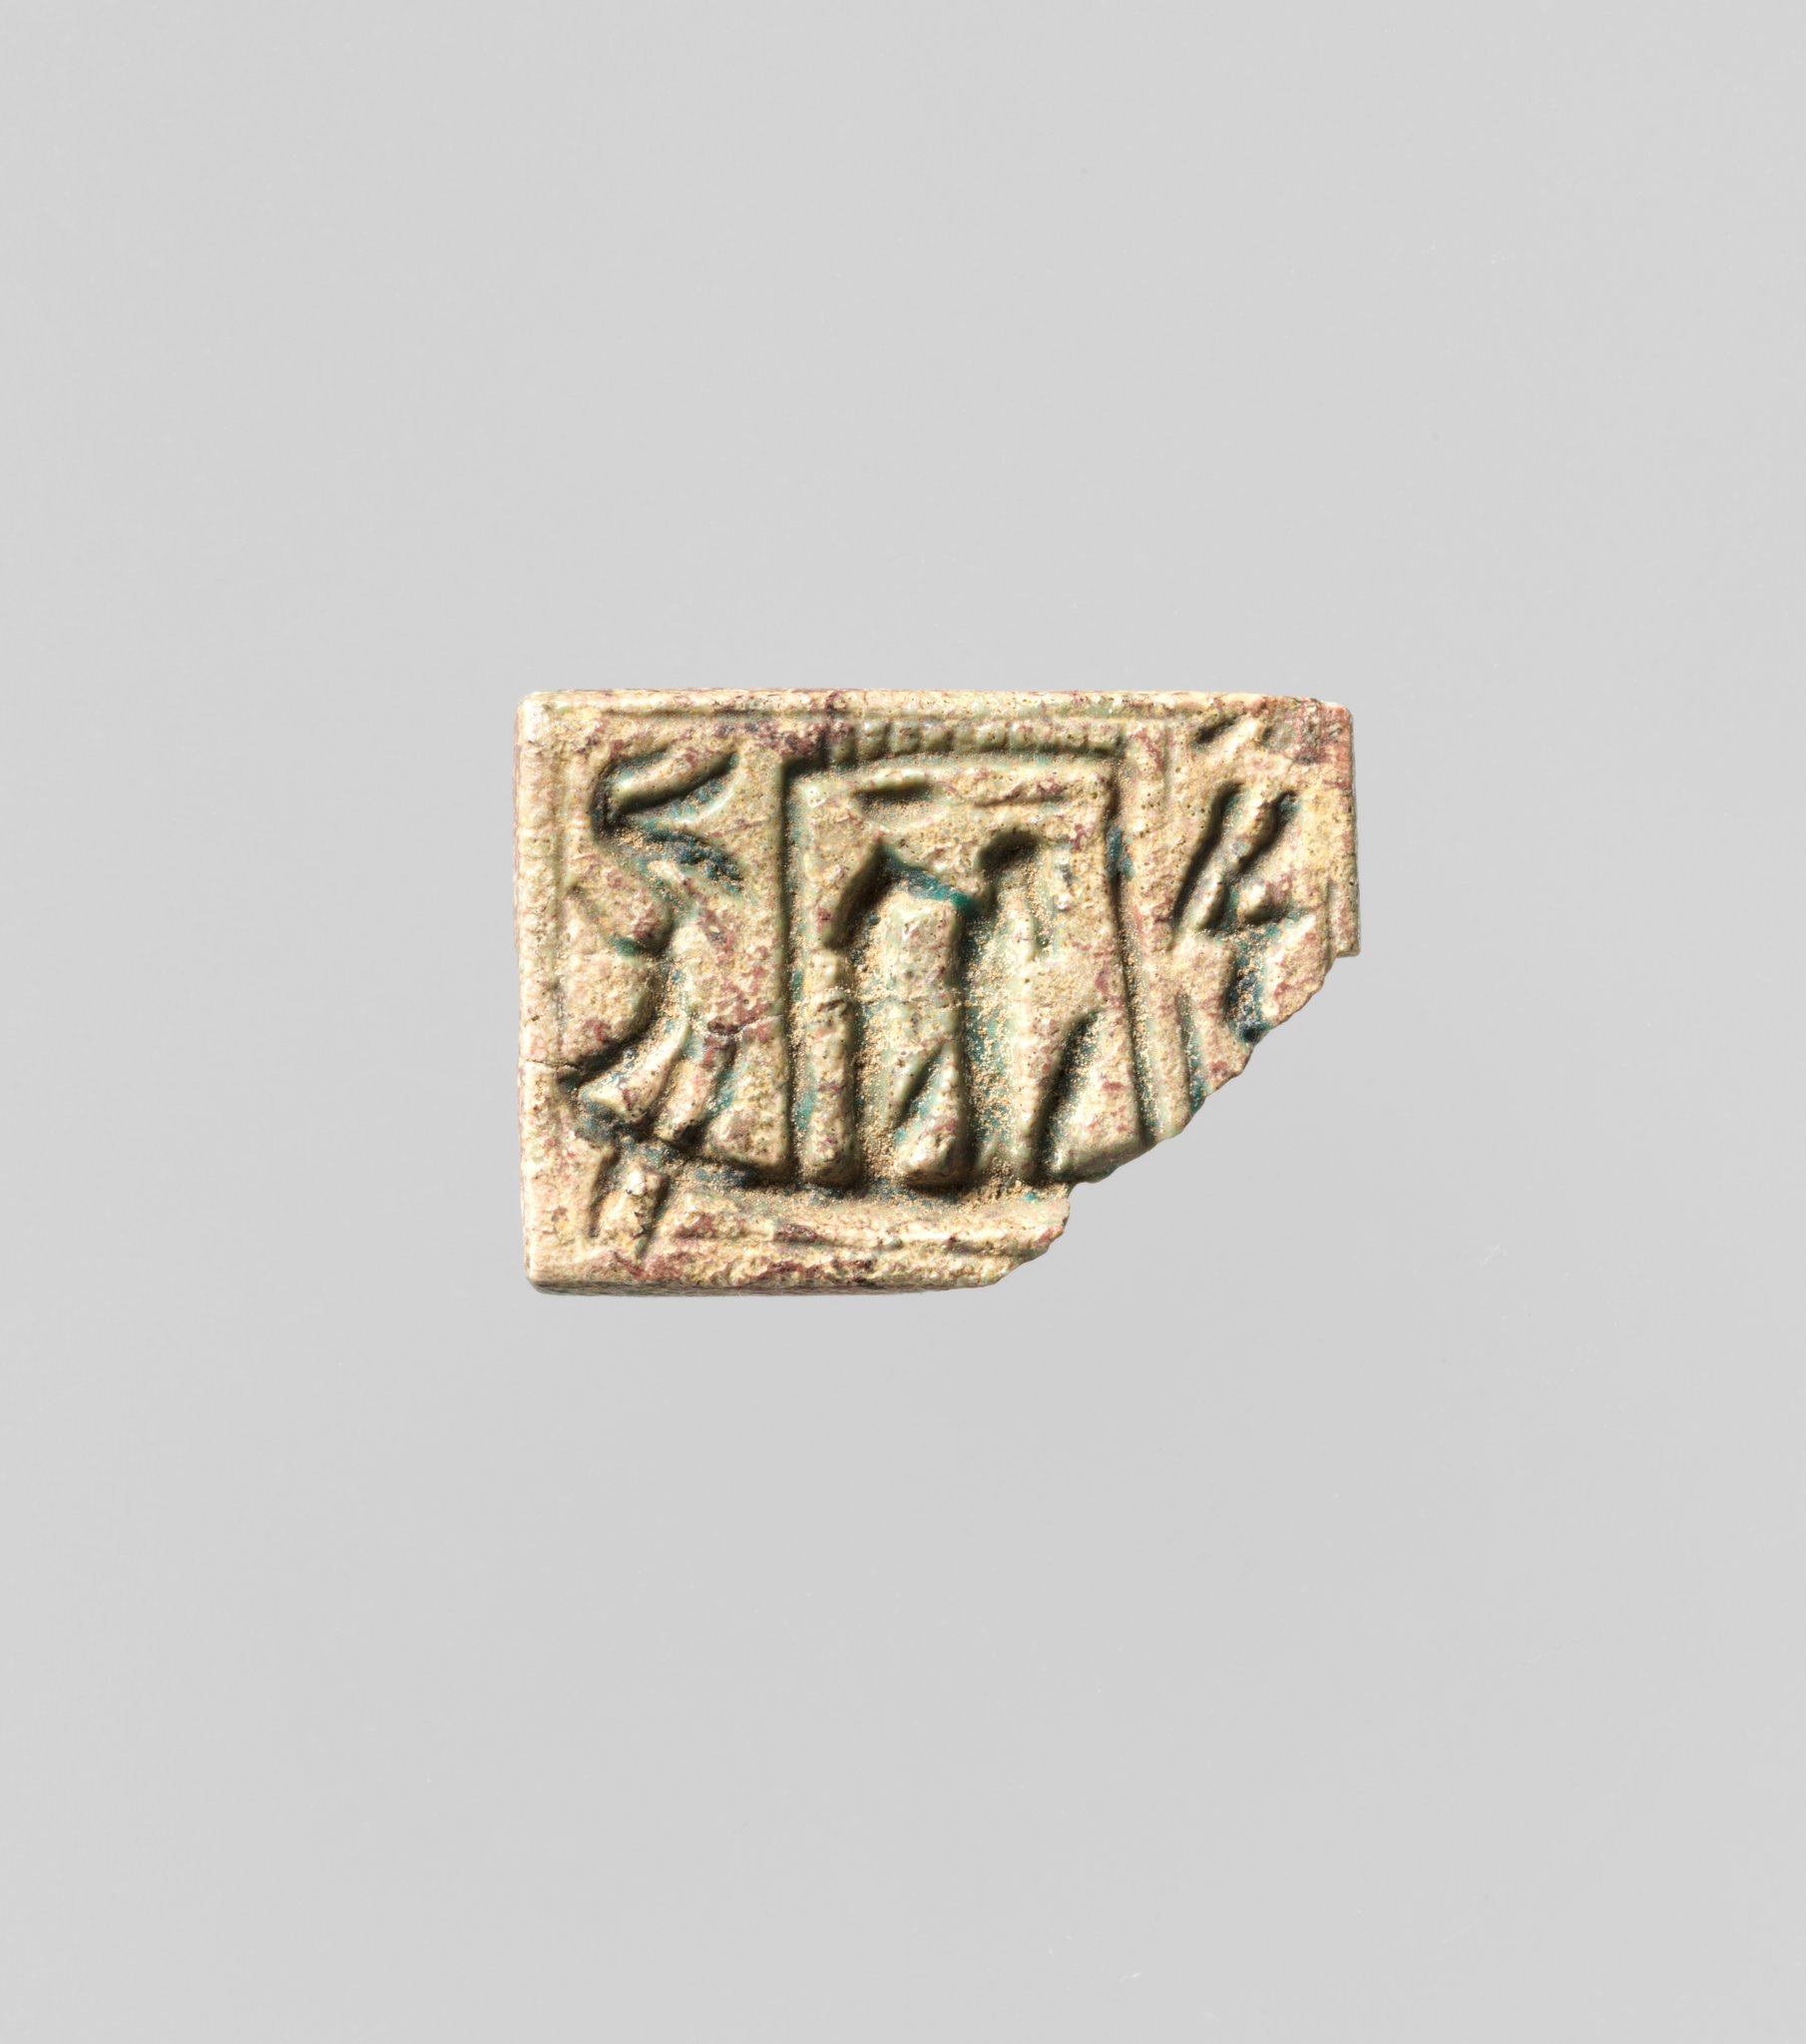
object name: plaque, boat, ptah, seth, shrine, winged uraeus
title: Plaque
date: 1295-1070 BCE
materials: stone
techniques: glazing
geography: egypt